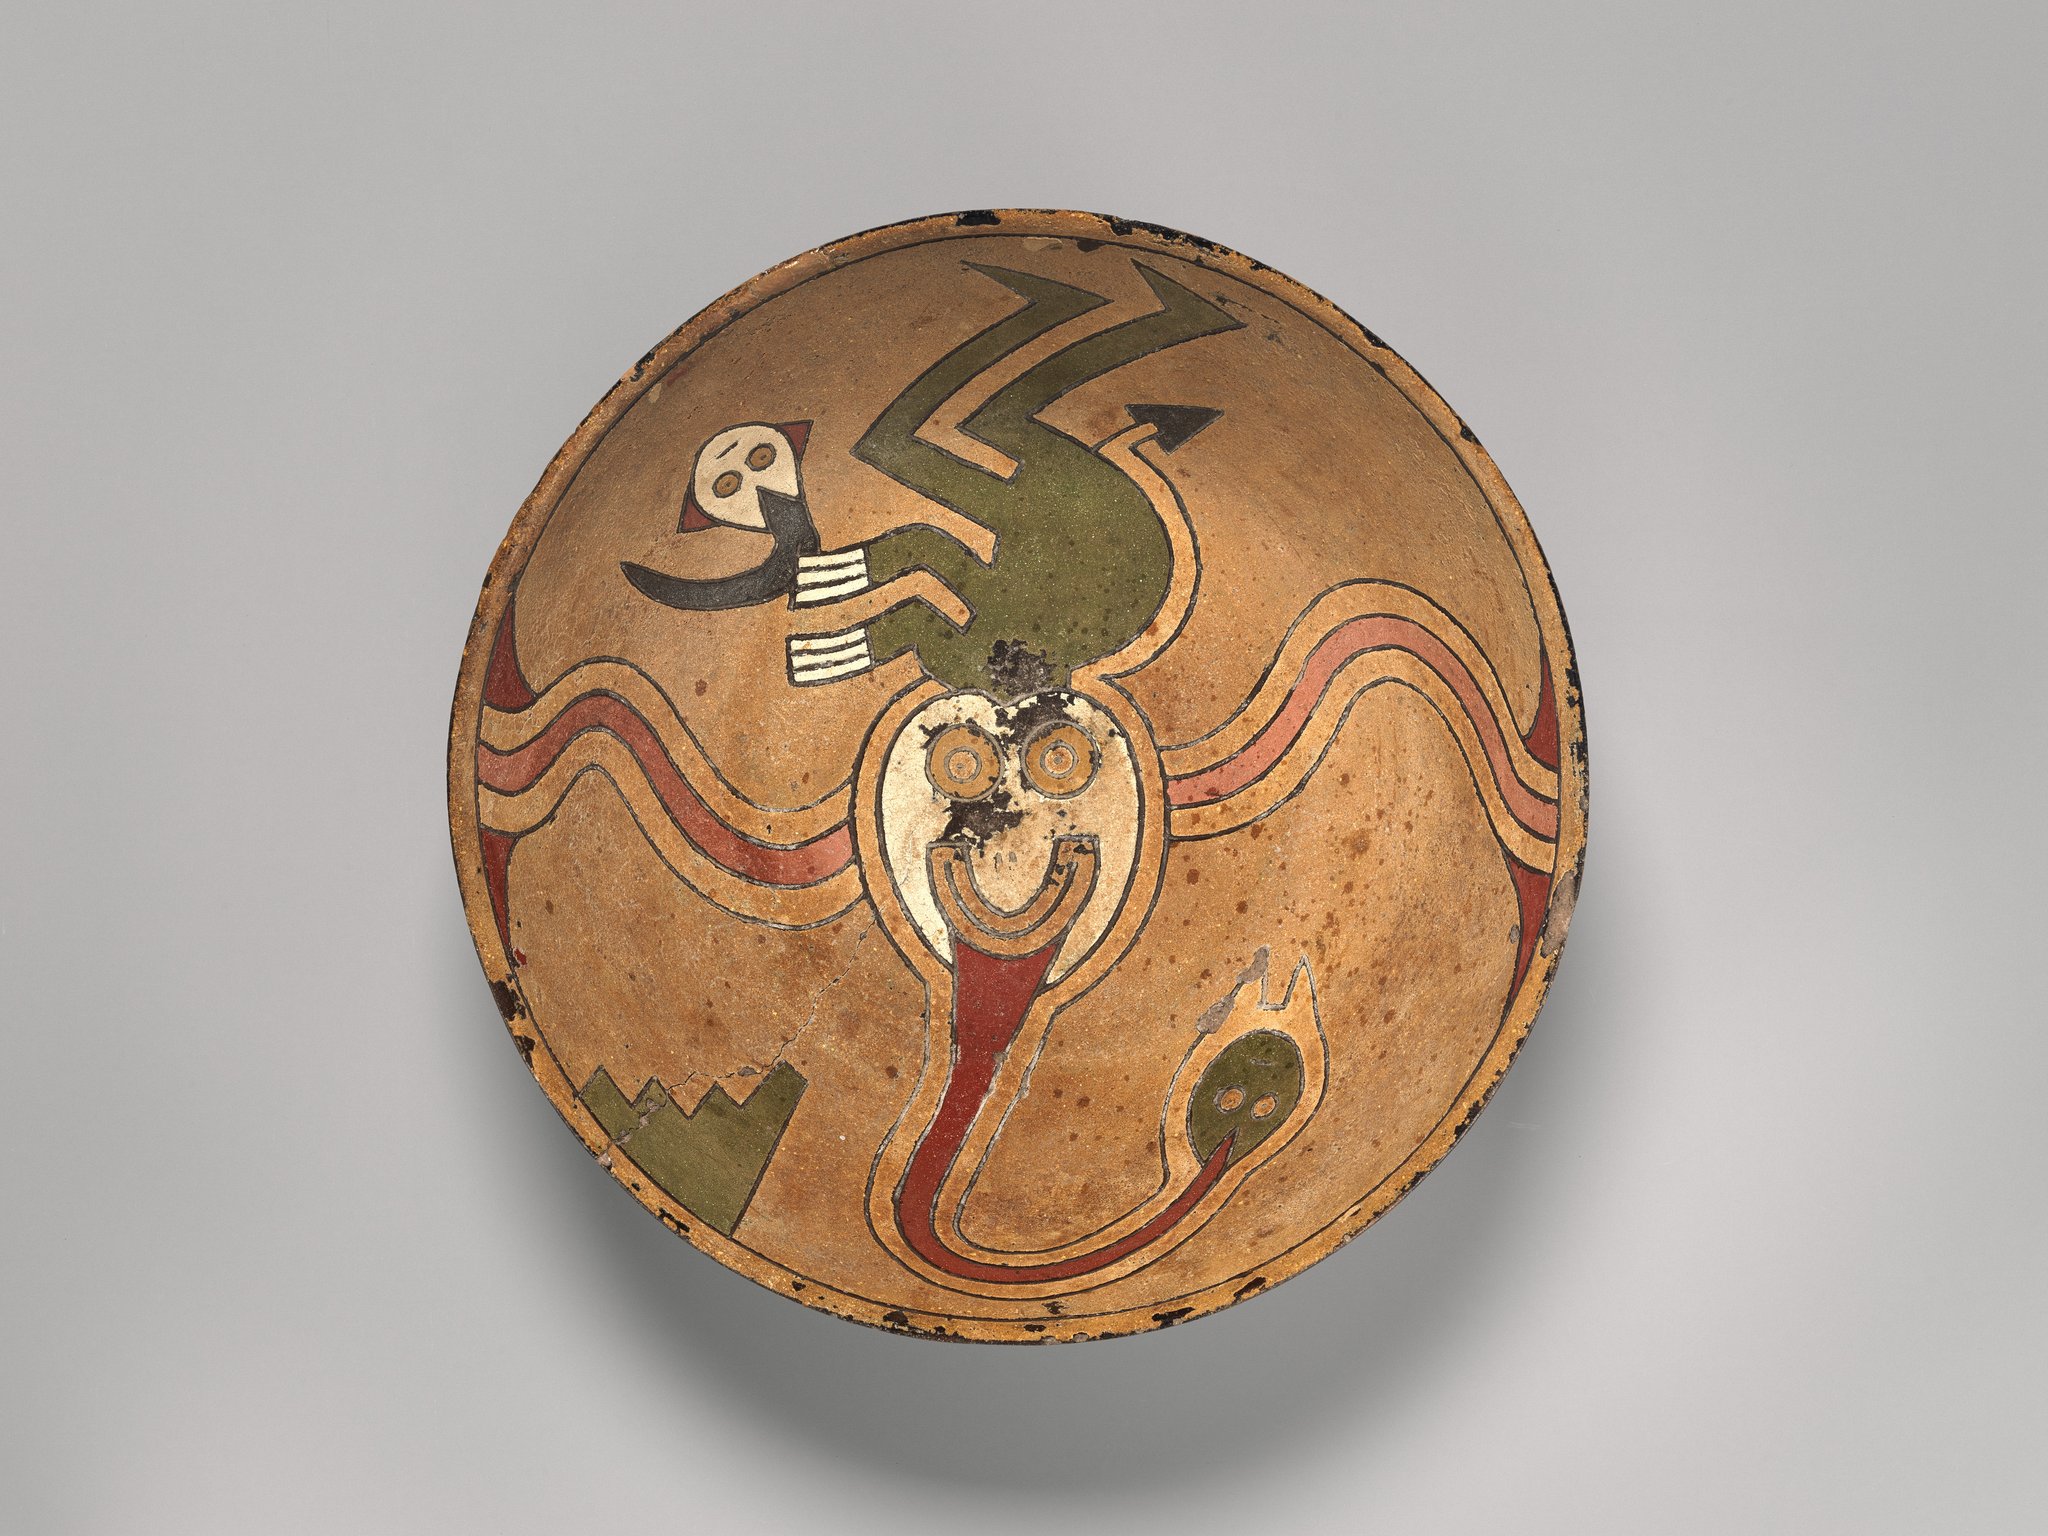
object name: bowl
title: Rattle bowl with flying figure (Oculate Being)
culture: paracas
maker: paracas artist(s)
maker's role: artist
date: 350 BCE-60 CE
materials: ceramic, paint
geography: peru